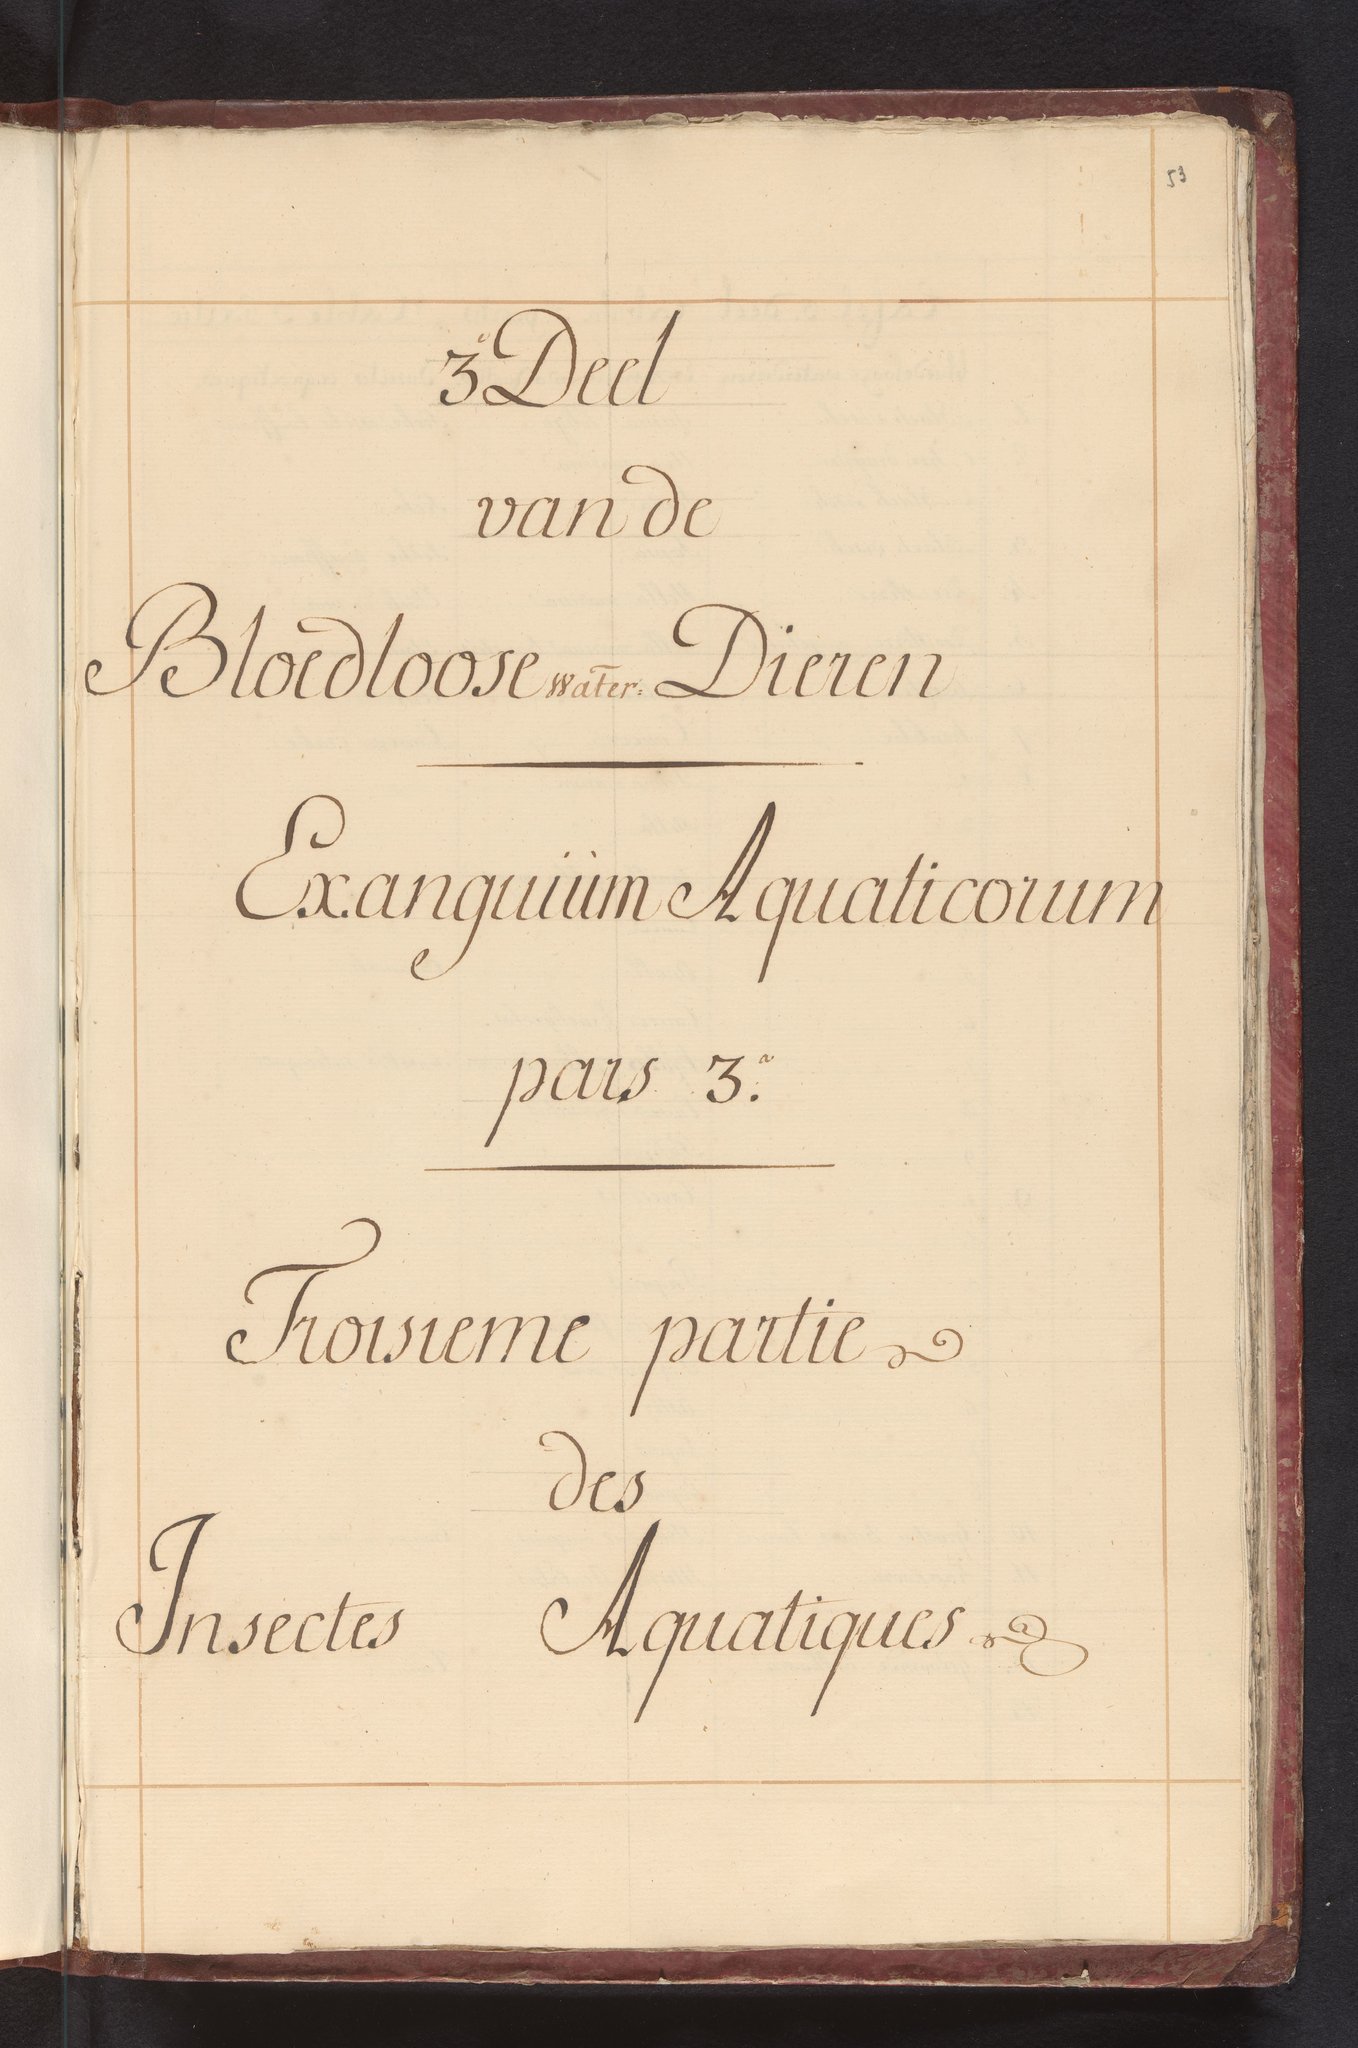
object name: manuscript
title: Titelpagina voor het derde deel met de weekdieren, schaaldieren en schelpen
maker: joseph van huerne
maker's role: kunstliefhebber, mecenas, verzamelaar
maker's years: 1752-1844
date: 1809-1814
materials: ink, paper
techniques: handwriting, pen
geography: bruges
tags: handwriting, written text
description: Handgeschreven titelpagina voor het derde deel met de weekdieren, schaaldieren en schelpen. Onderdeel van het zesde album met tekeningen van vissen, schelpen en insekten. Zesde van twaalf albums met tekeningen van dieren, vogels en planten bekend rond 1600, gemaakt in opdracht van keizer Rudolf II. Met toelichting in Nederlands, Latijn en Frans.